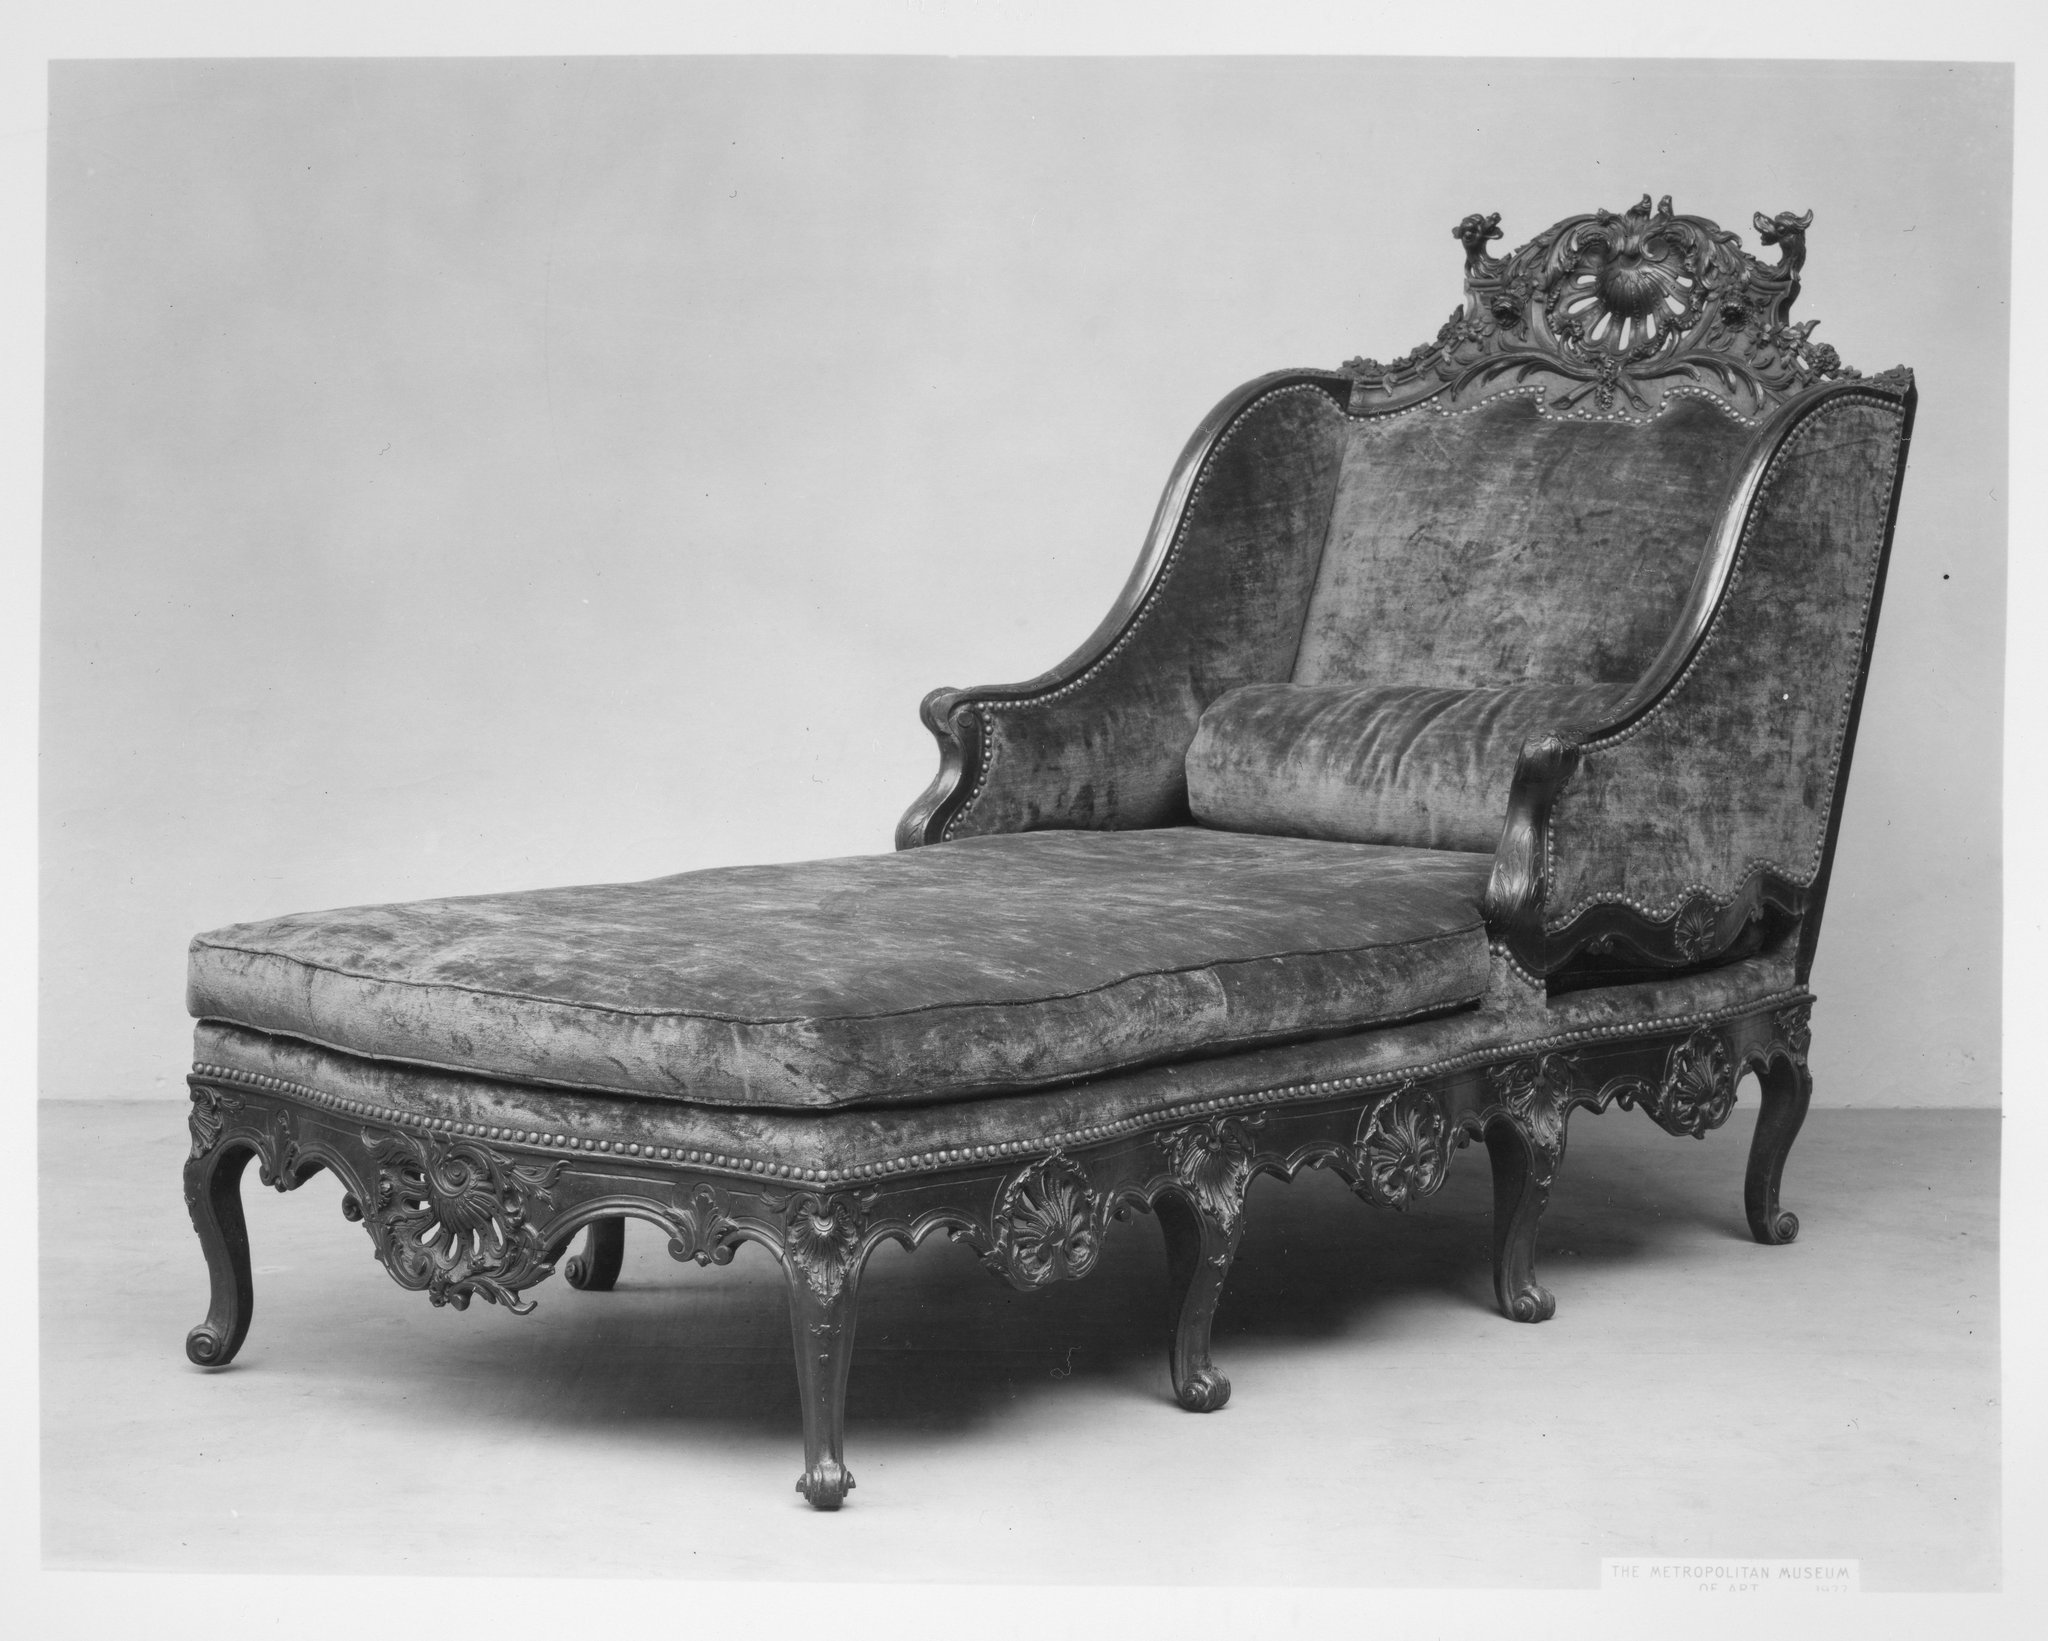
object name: daybed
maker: school of toulon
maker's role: maker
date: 1726-1750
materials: wood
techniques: carving, damask